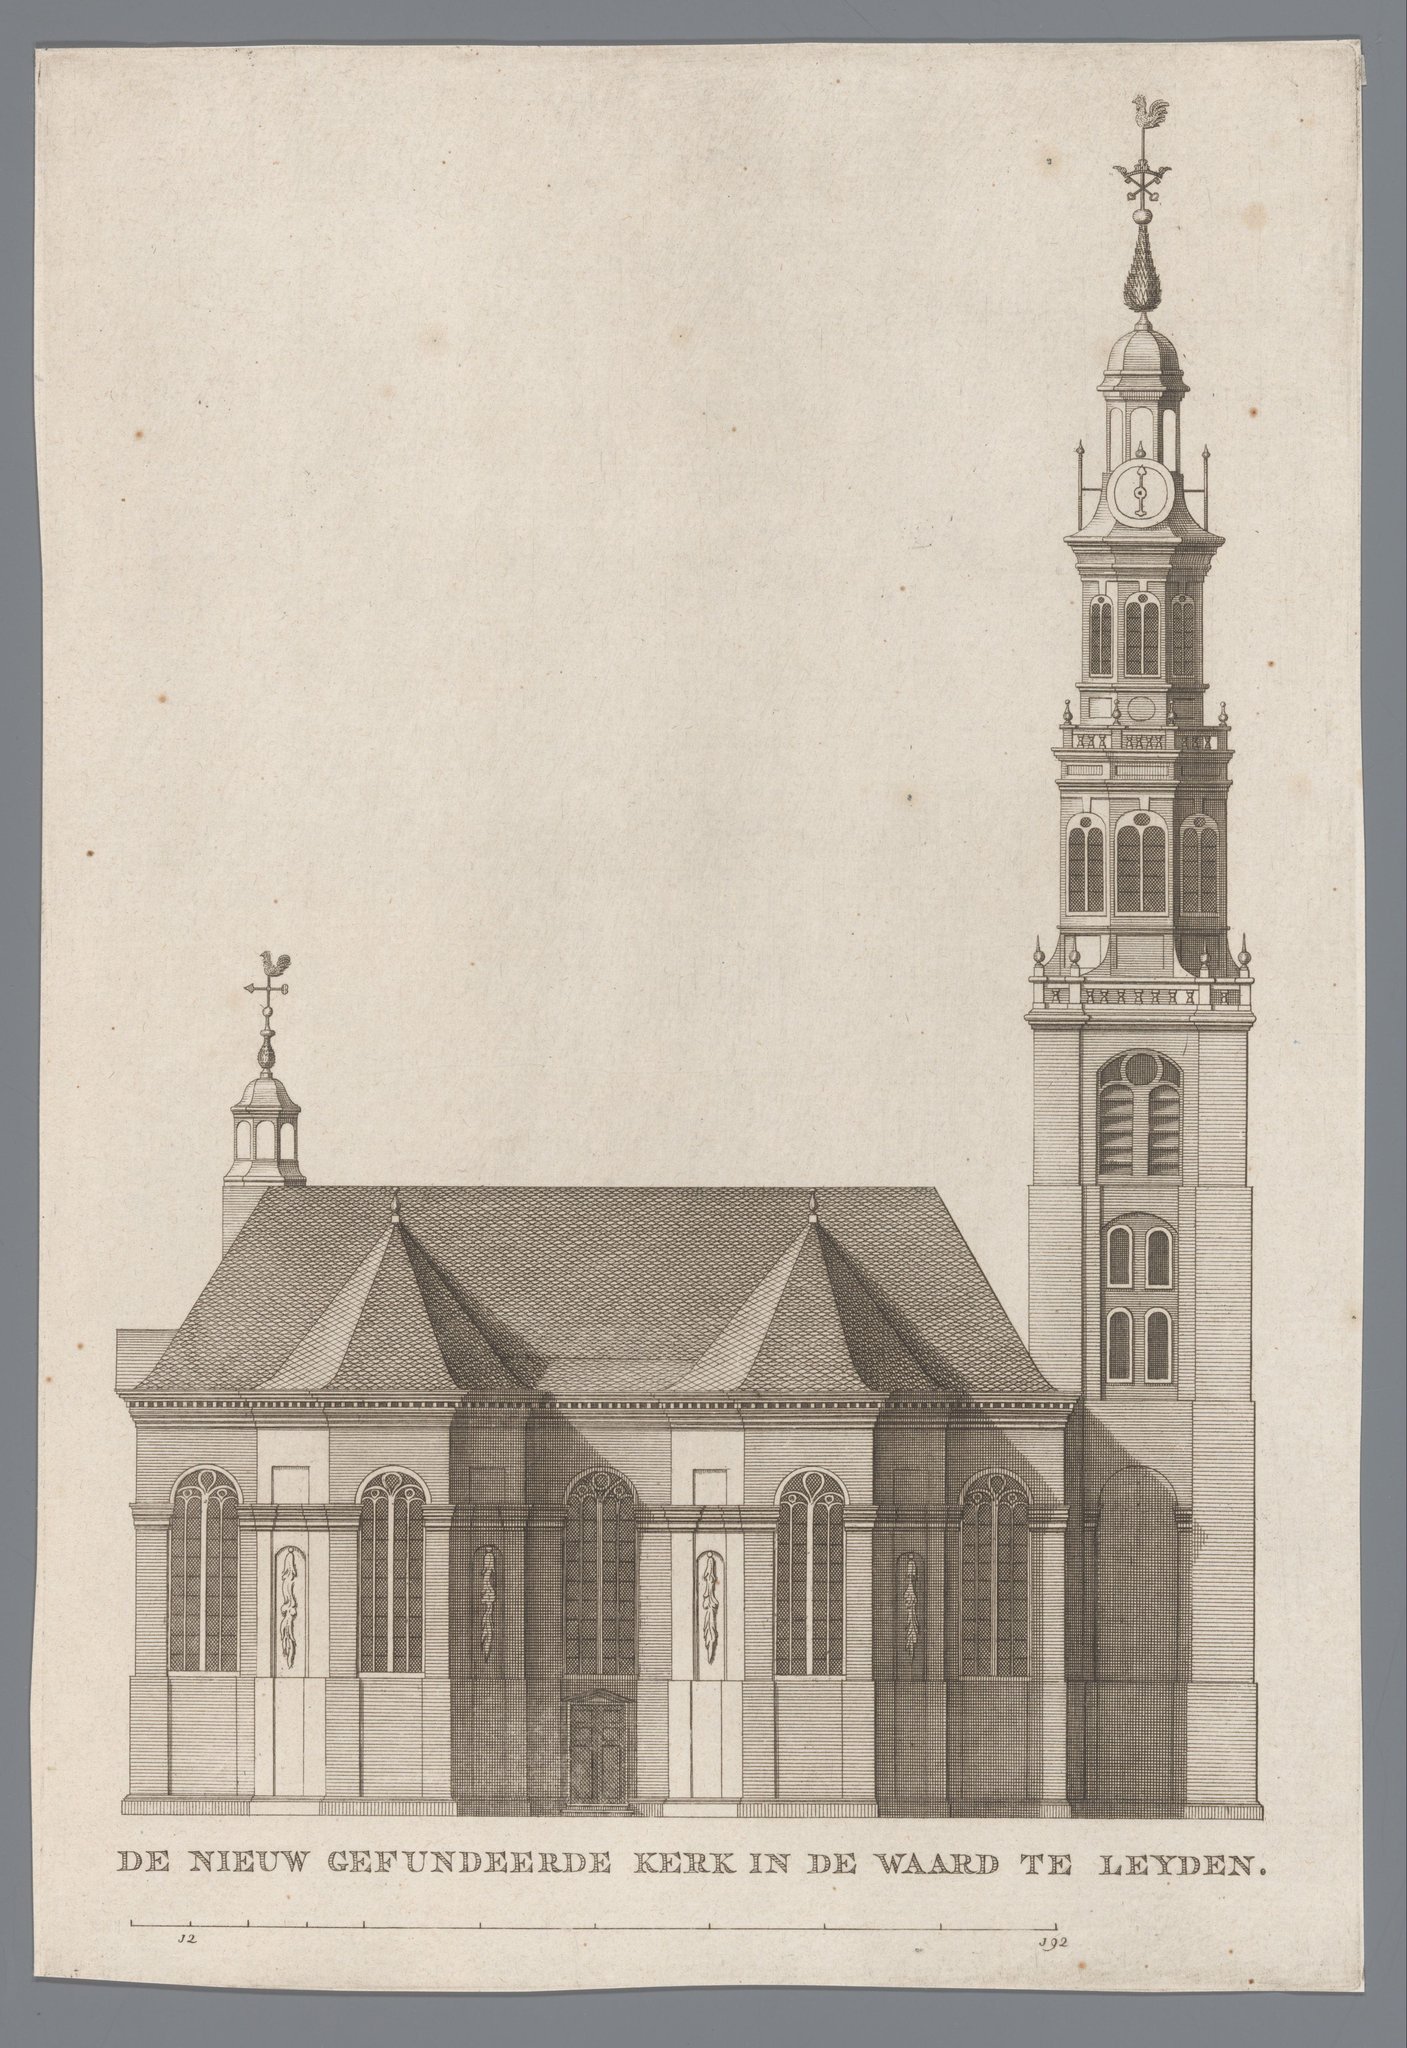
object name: print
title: De Nieuw Gefundeerde Kerk in de Waard te Leyden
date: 1784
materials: paper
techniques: engraving, etching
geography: leiden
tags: church (exterior), leiden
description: Prent uit: Beschrijving der stad Leyden, haar gelegenheid, oorsprong (...). Leiden: Cornelis Heyligert en Abraham en Jan Honkoop, 1784, dl. 3, tussen p. 986 en 987.